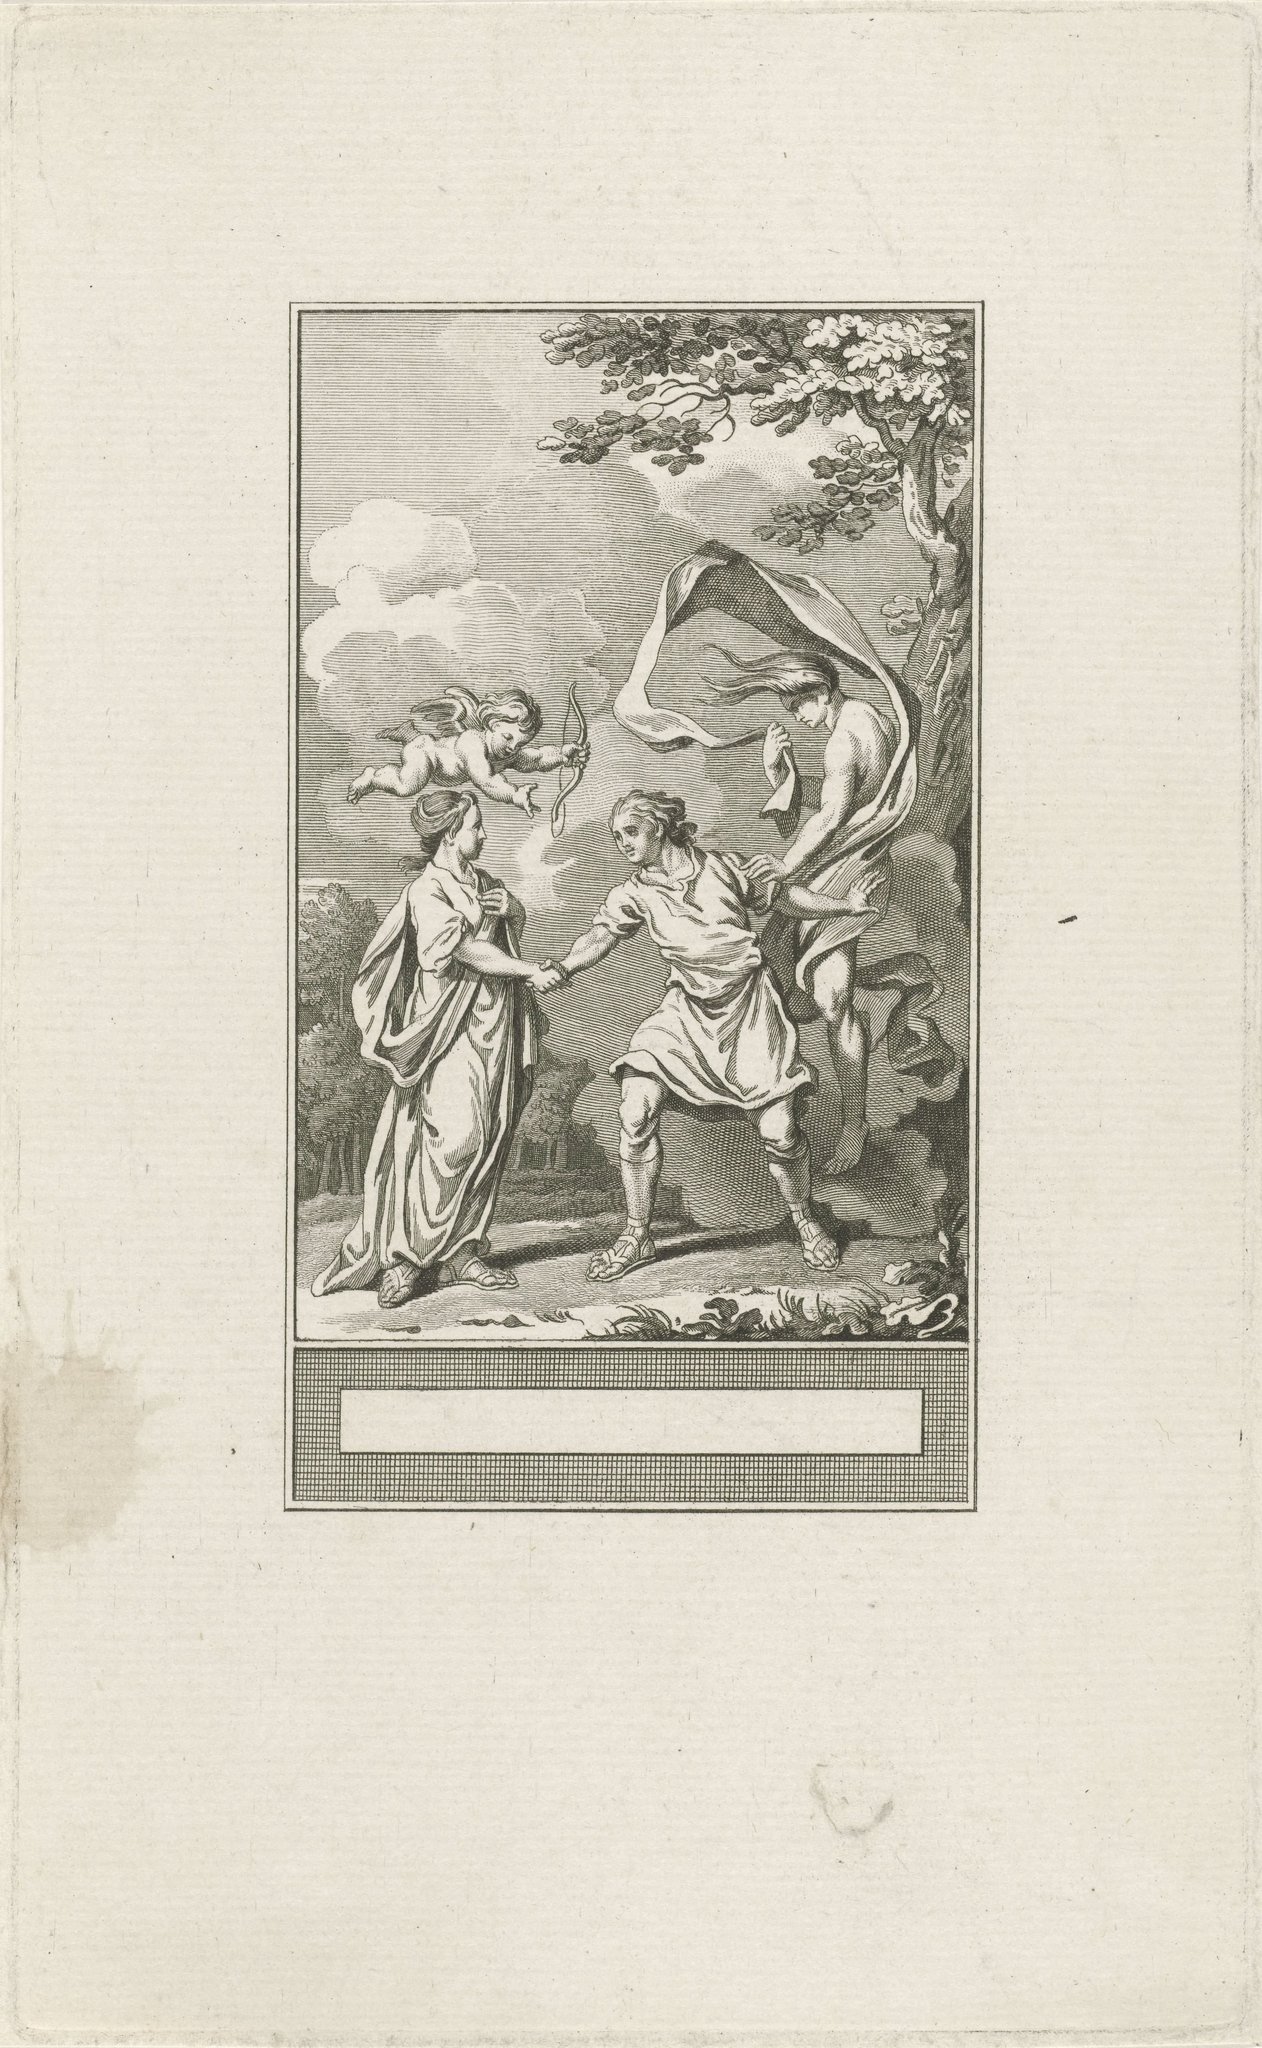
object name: print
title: Wedijver tussen Fortuin en de Liefde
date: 1778-1785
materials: paper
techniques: etching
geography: amsterdam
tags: fortune and misfortune, (story of) cupid, amor (eros), couple of lovers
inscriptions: collector's mark: Lugt 2228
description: Latere staat bij: Gellert, Christian Fürchtegott. Fabelen en vertelsels. 3 dln. Amsterdam: Pieter Meyer, 1772-1774. De prenten bij deze publicatie werden later uitgegeven. De exemplaren uitgegeven door de weduwe Jacobus Loveringh & Johannes Allart tussen 1777 en 1778, de exemplaren uitgegeven door alleen Johannes Allart tussen 1778 en 1785.